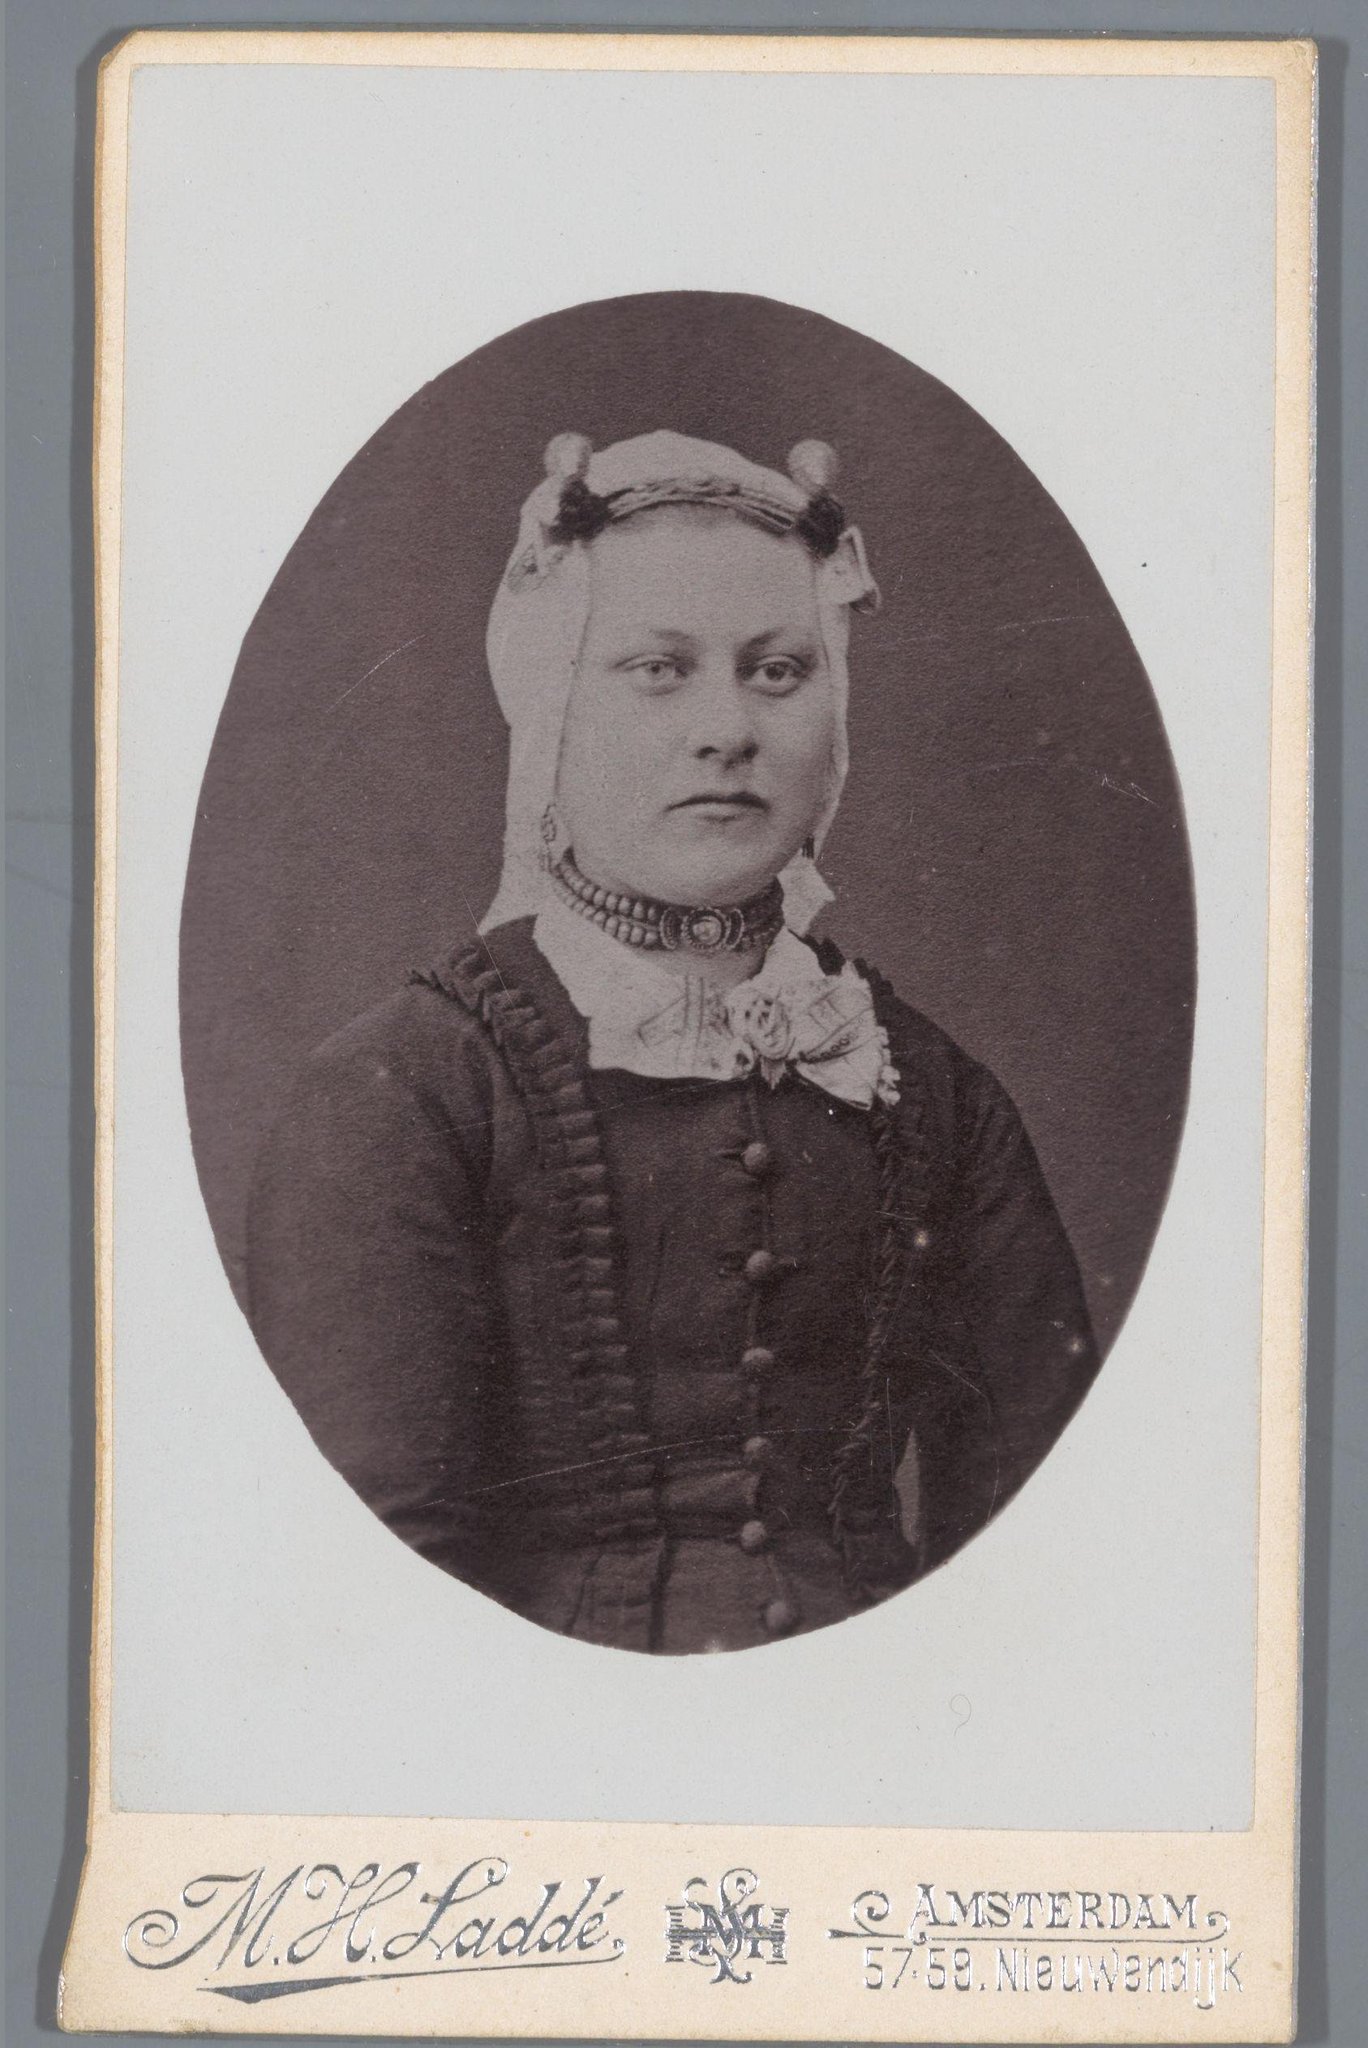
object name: photograph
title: Portret van een onbekende vrouw, aangeduid als de vrouw van Jan Ton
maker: machiel hendricus laddé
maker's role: fotograaf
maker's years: 1866-1932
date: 1892-1906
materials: cardboard, photographic support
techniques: collodion silver print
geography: amsterdam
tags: historical persons - bb - woman, head-gear: cap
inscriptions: inscription: ‘vrouw van Jan Ton’, inscription: ‘Photographie/ Artistique/ M. H. LADDÉ/ BOVEN DE FIRMA/ MERKELBACH & CO./ AMSTERDAM/ 57-59/ NIEUWENDIJK/ Het Cliché wordt voor verdere bestellingen bewaard/ L. GEVAERT & Co. VIEUX-DIEU.’